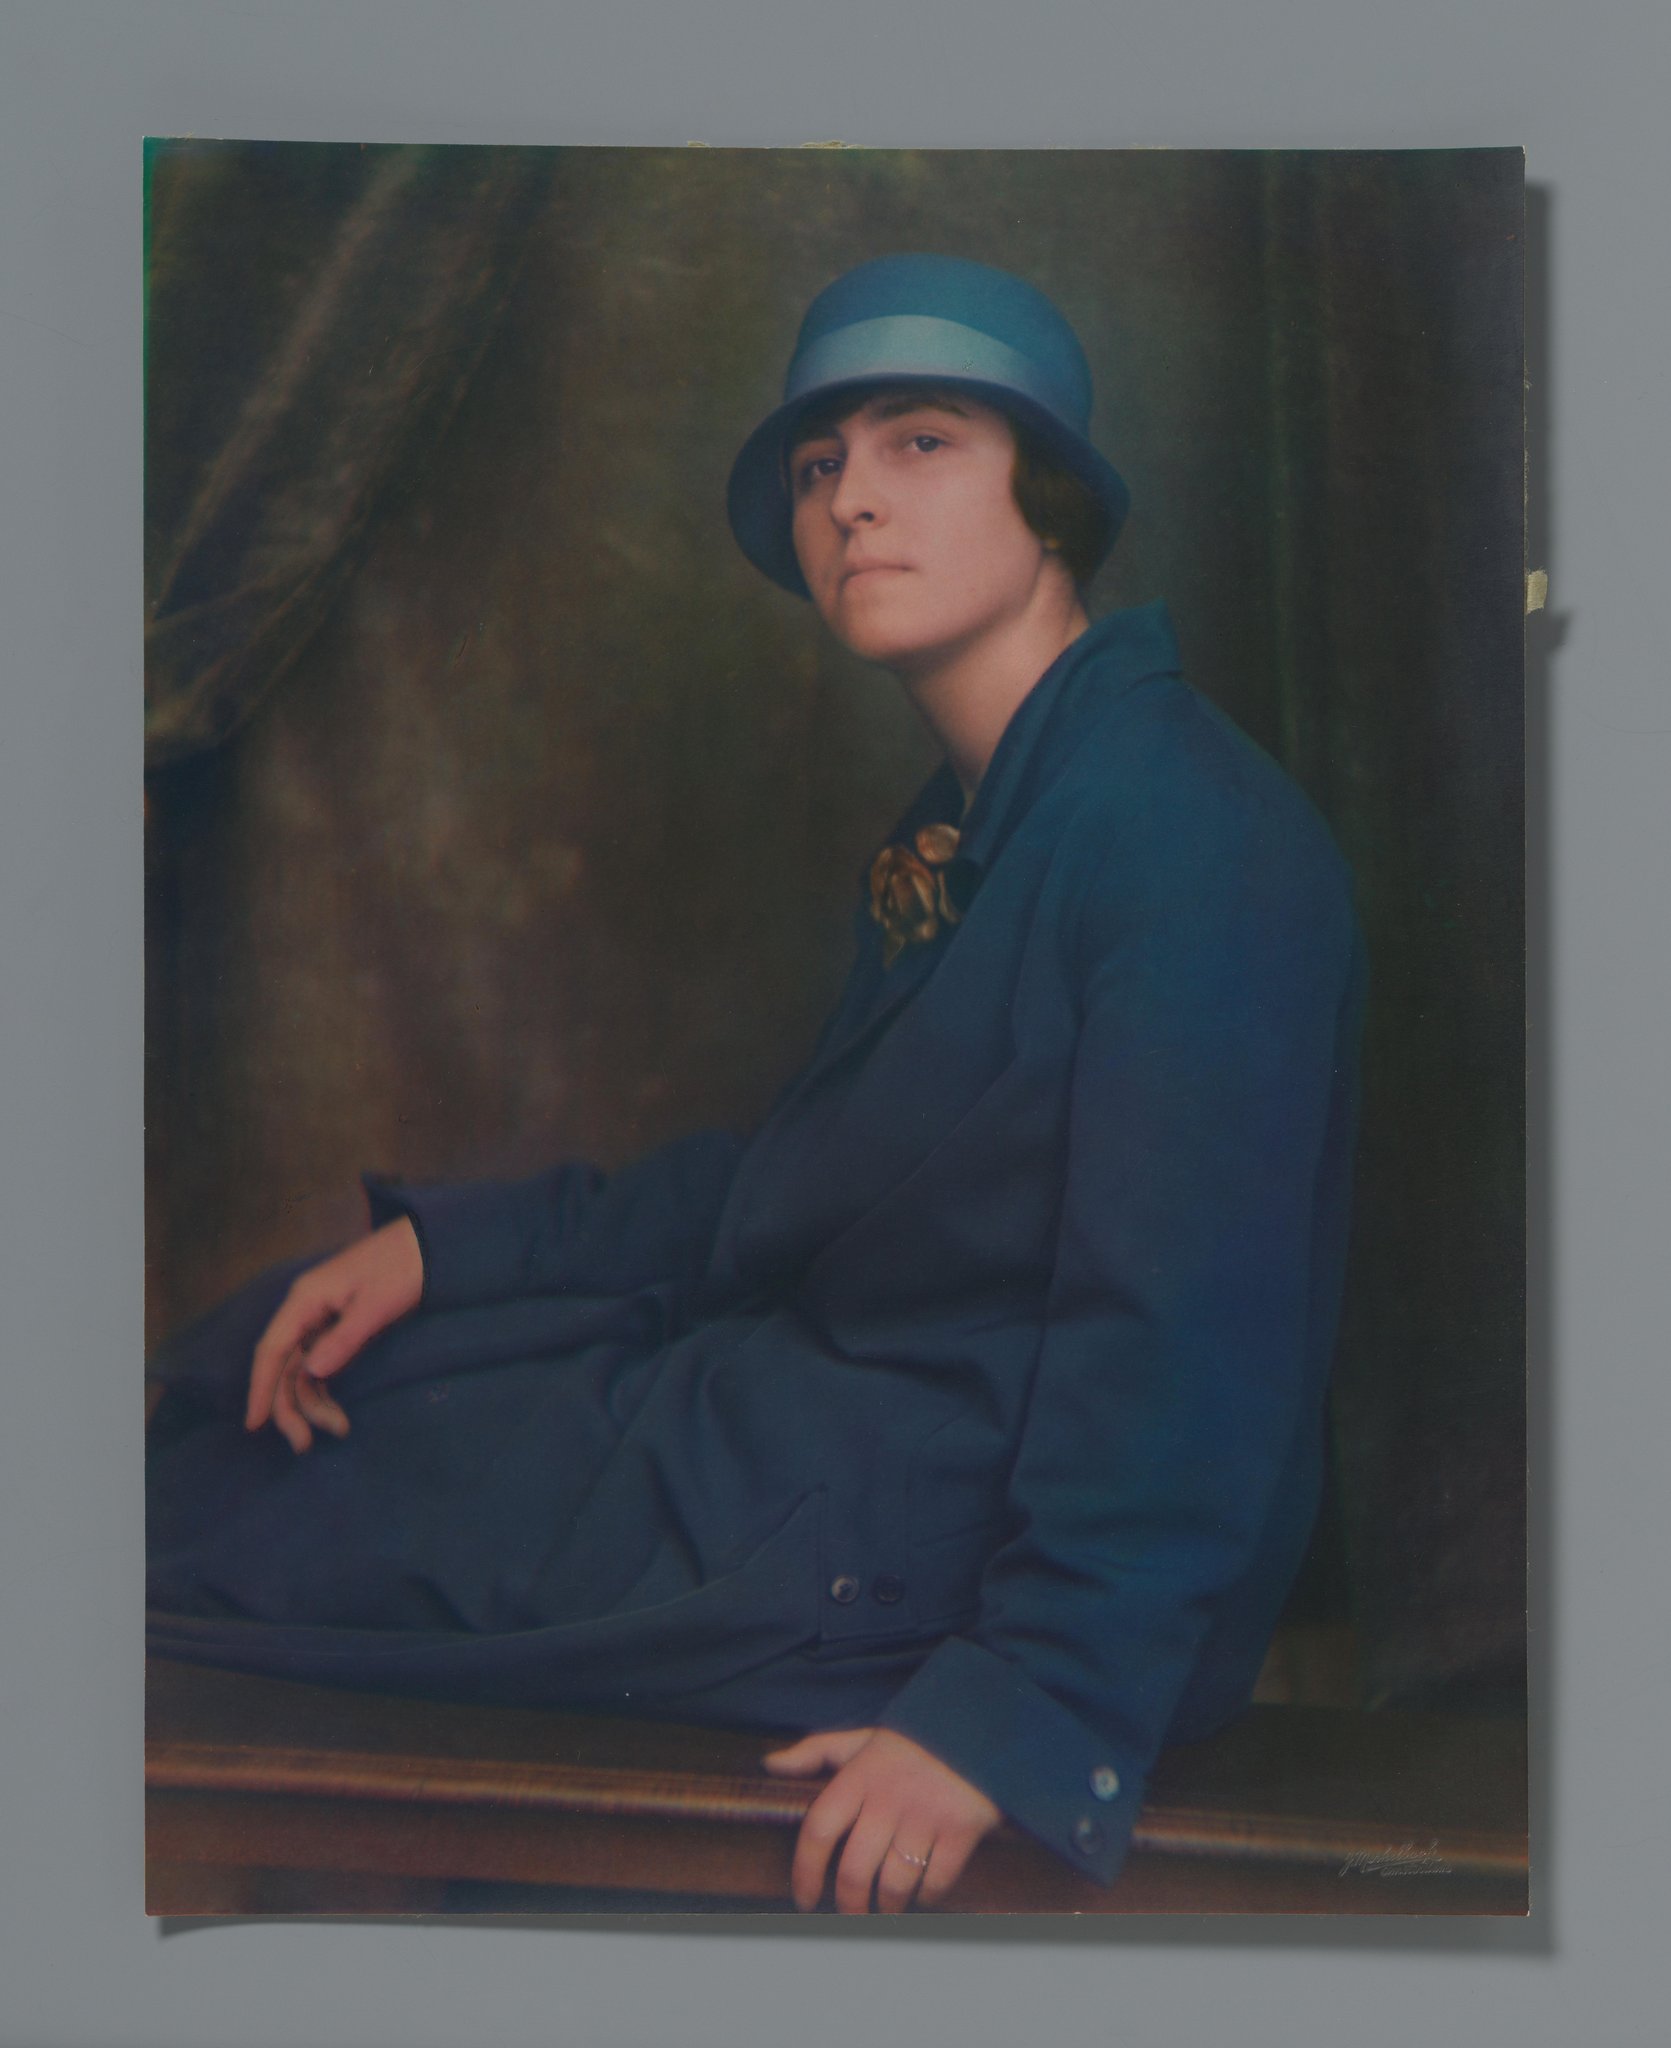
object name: photograph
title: Portret van Mies Rosenboom-Merkelbach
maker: jacob merkelbach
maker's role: fotograaf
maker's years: 1877-1942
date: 1920-1930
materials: paper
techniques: jos-pé print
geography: amsterdam